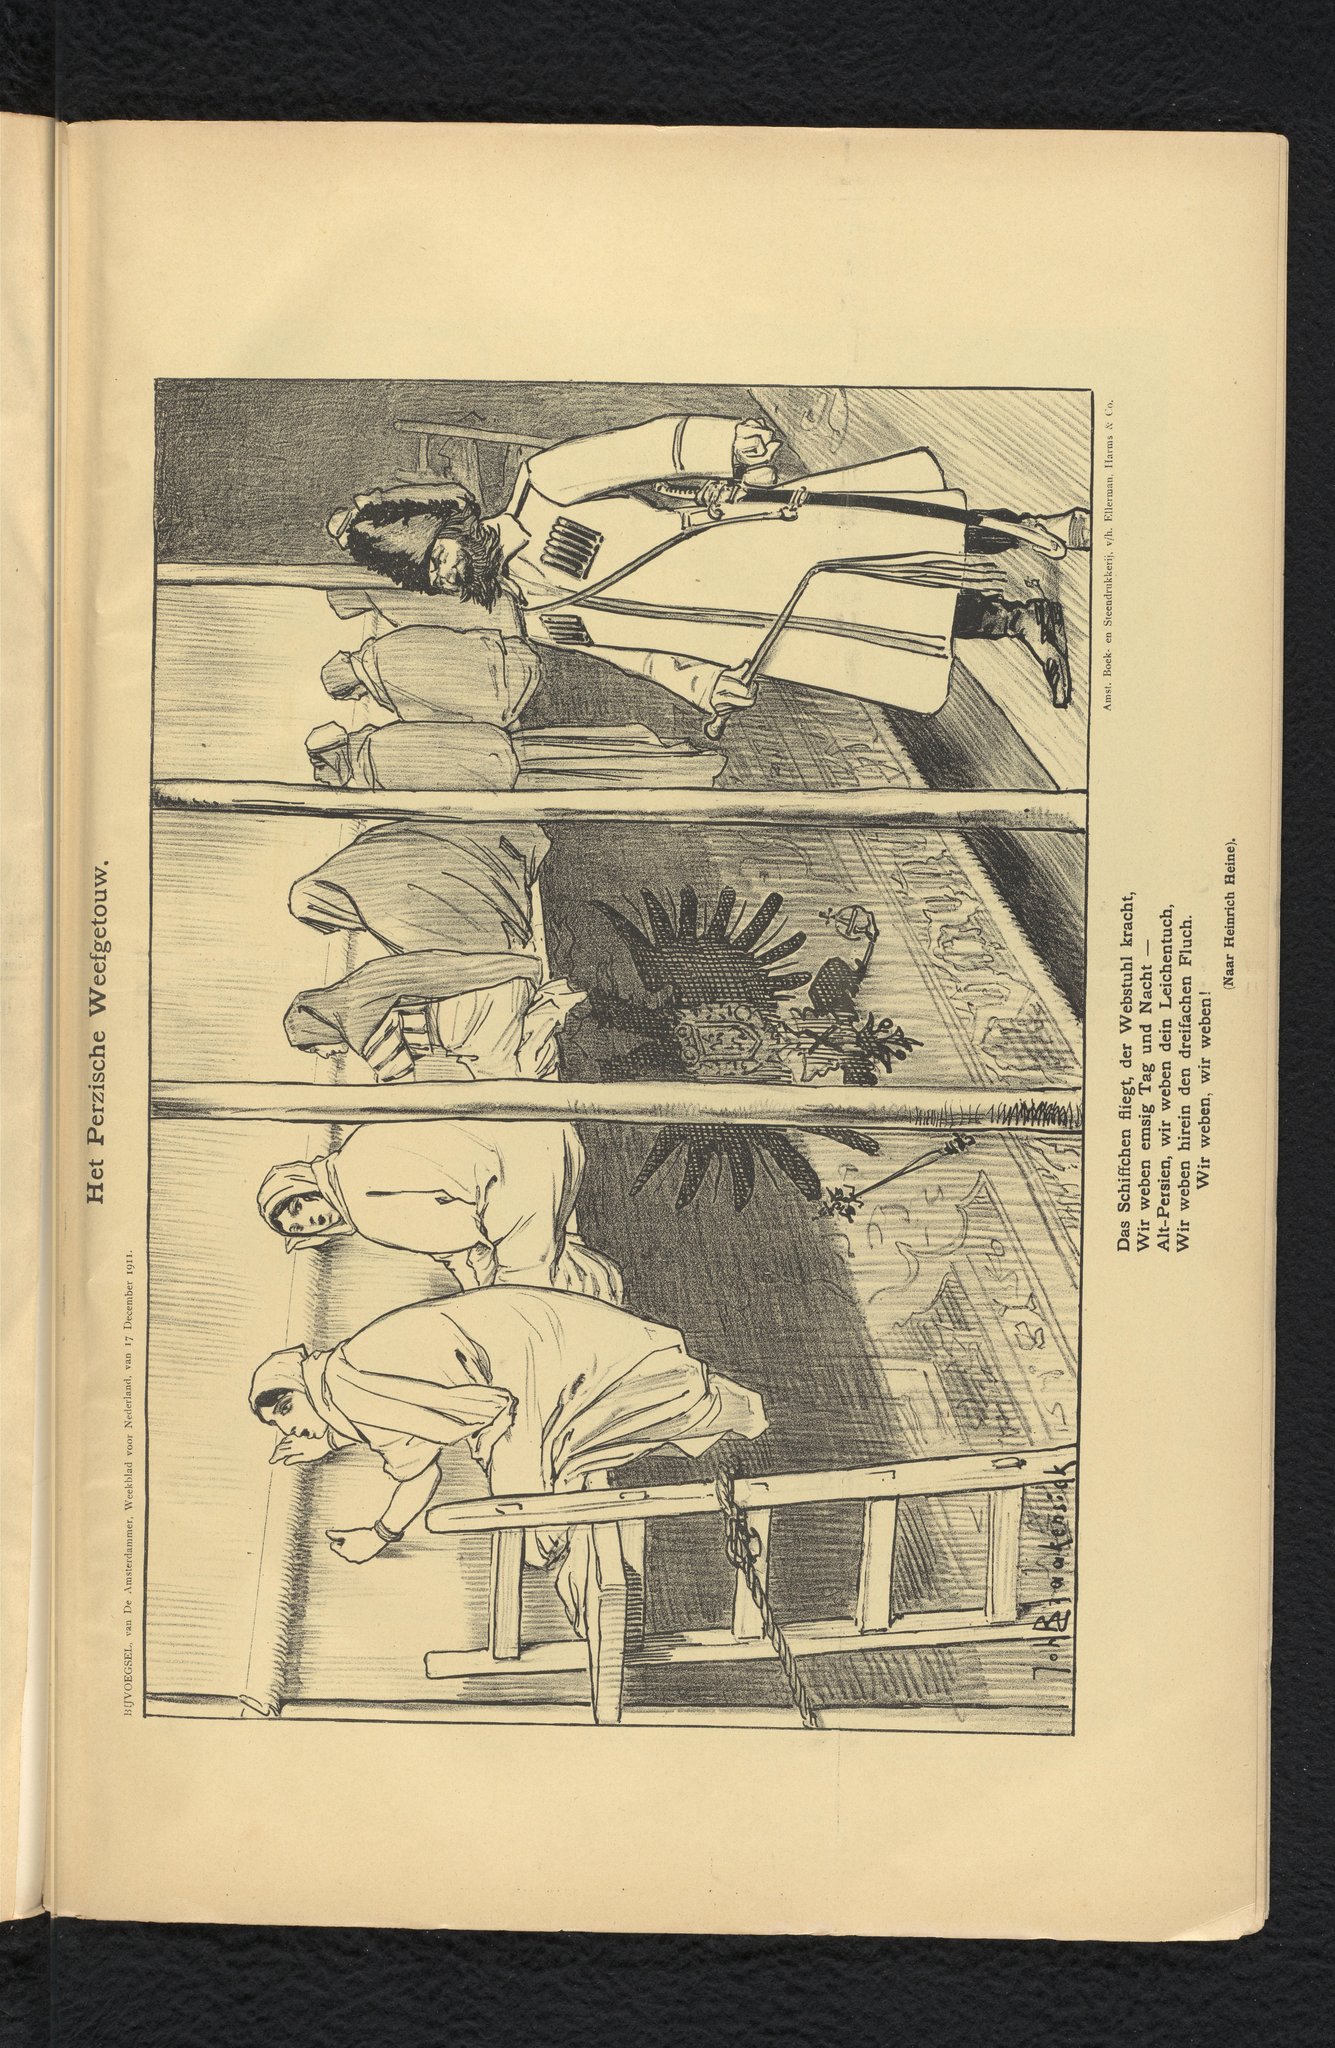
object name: cartoon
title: Het Perzische Weefgetouw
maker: johan braakensiek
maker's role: draughtsman, print maker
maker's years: 1858-1940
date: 1911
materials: paper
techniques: lithograph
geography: netherlands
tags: carpet, rug, weaving-loom, political caricatures and satires, persia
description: Onder toezicht van een Russische soldaat met zweep worden Perzische vrouwen gedwongen een tapijt te weven met het Russische wapen met de tweekoppige adelaar.